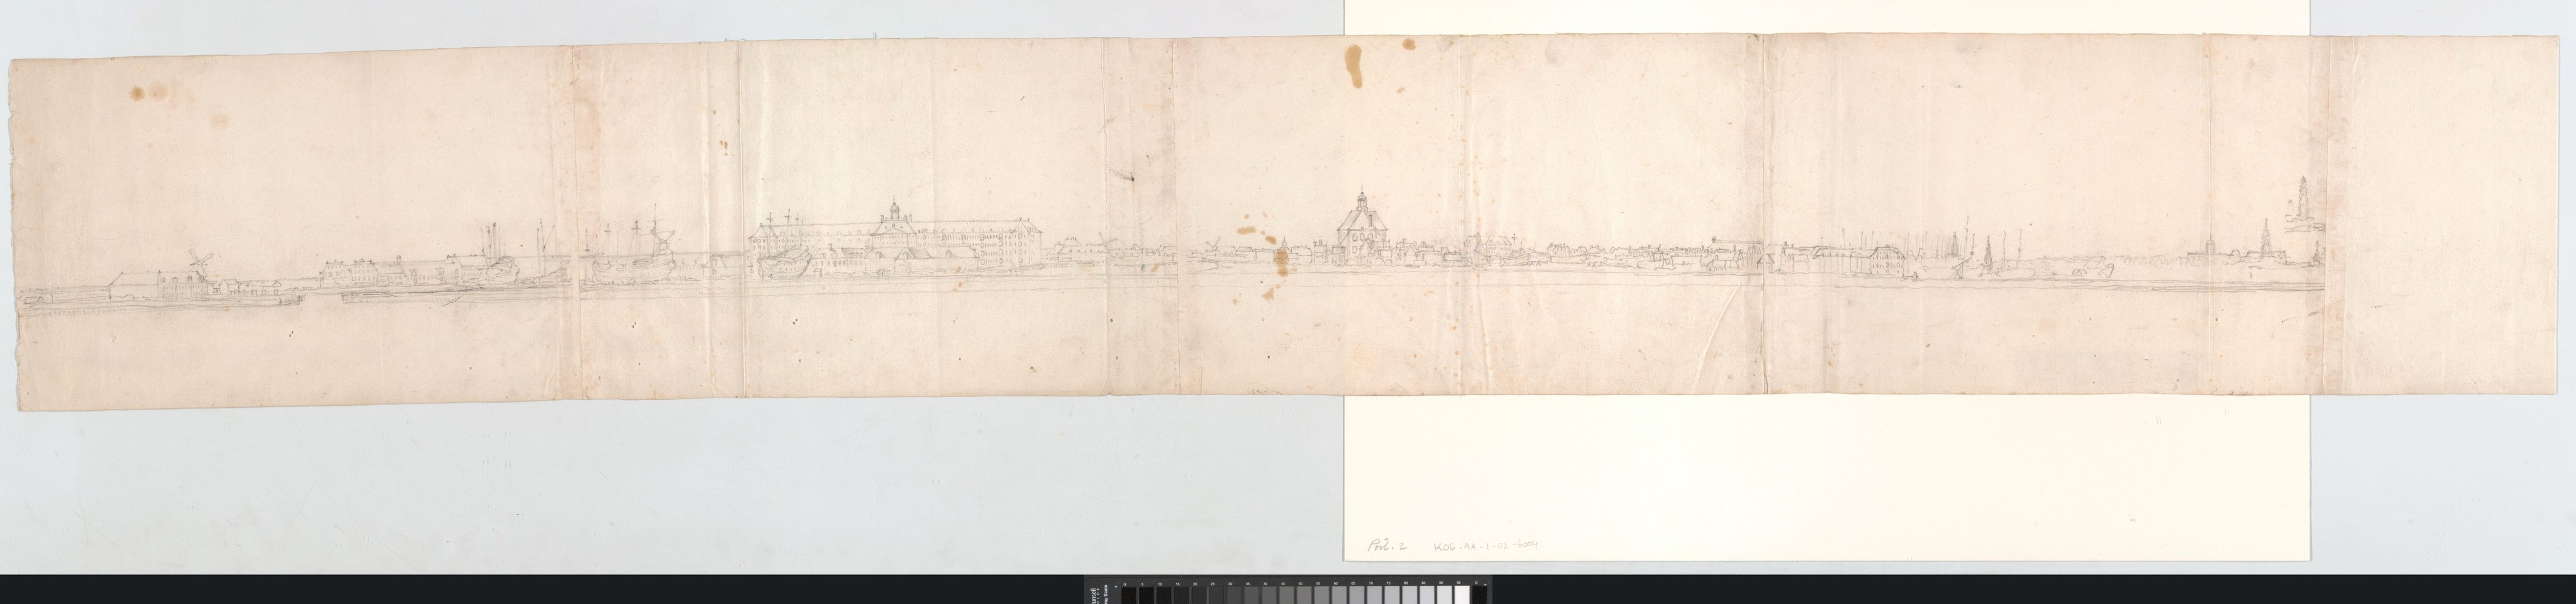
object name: drawing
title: Gezicht op Amsterdam vanaf de Hoogte Kadijk tot de Muiderpoort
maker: Anonymous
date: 1700-1799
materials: paper, pencil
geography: amsterdam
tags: city-view in general; 'veduta', amsterdam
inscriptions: inscription: ‘Geschenk v. d. W= C. Schöffer / Nov. 1880/ / 35’, inscription: ‘Port. 2’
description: Onderwerpsrubriek binnen de Atlas Amsterdam: Gezichten van het IJ op het Oostelijk gedeelte der stad, Nieuwebrug tot Zeeburg.